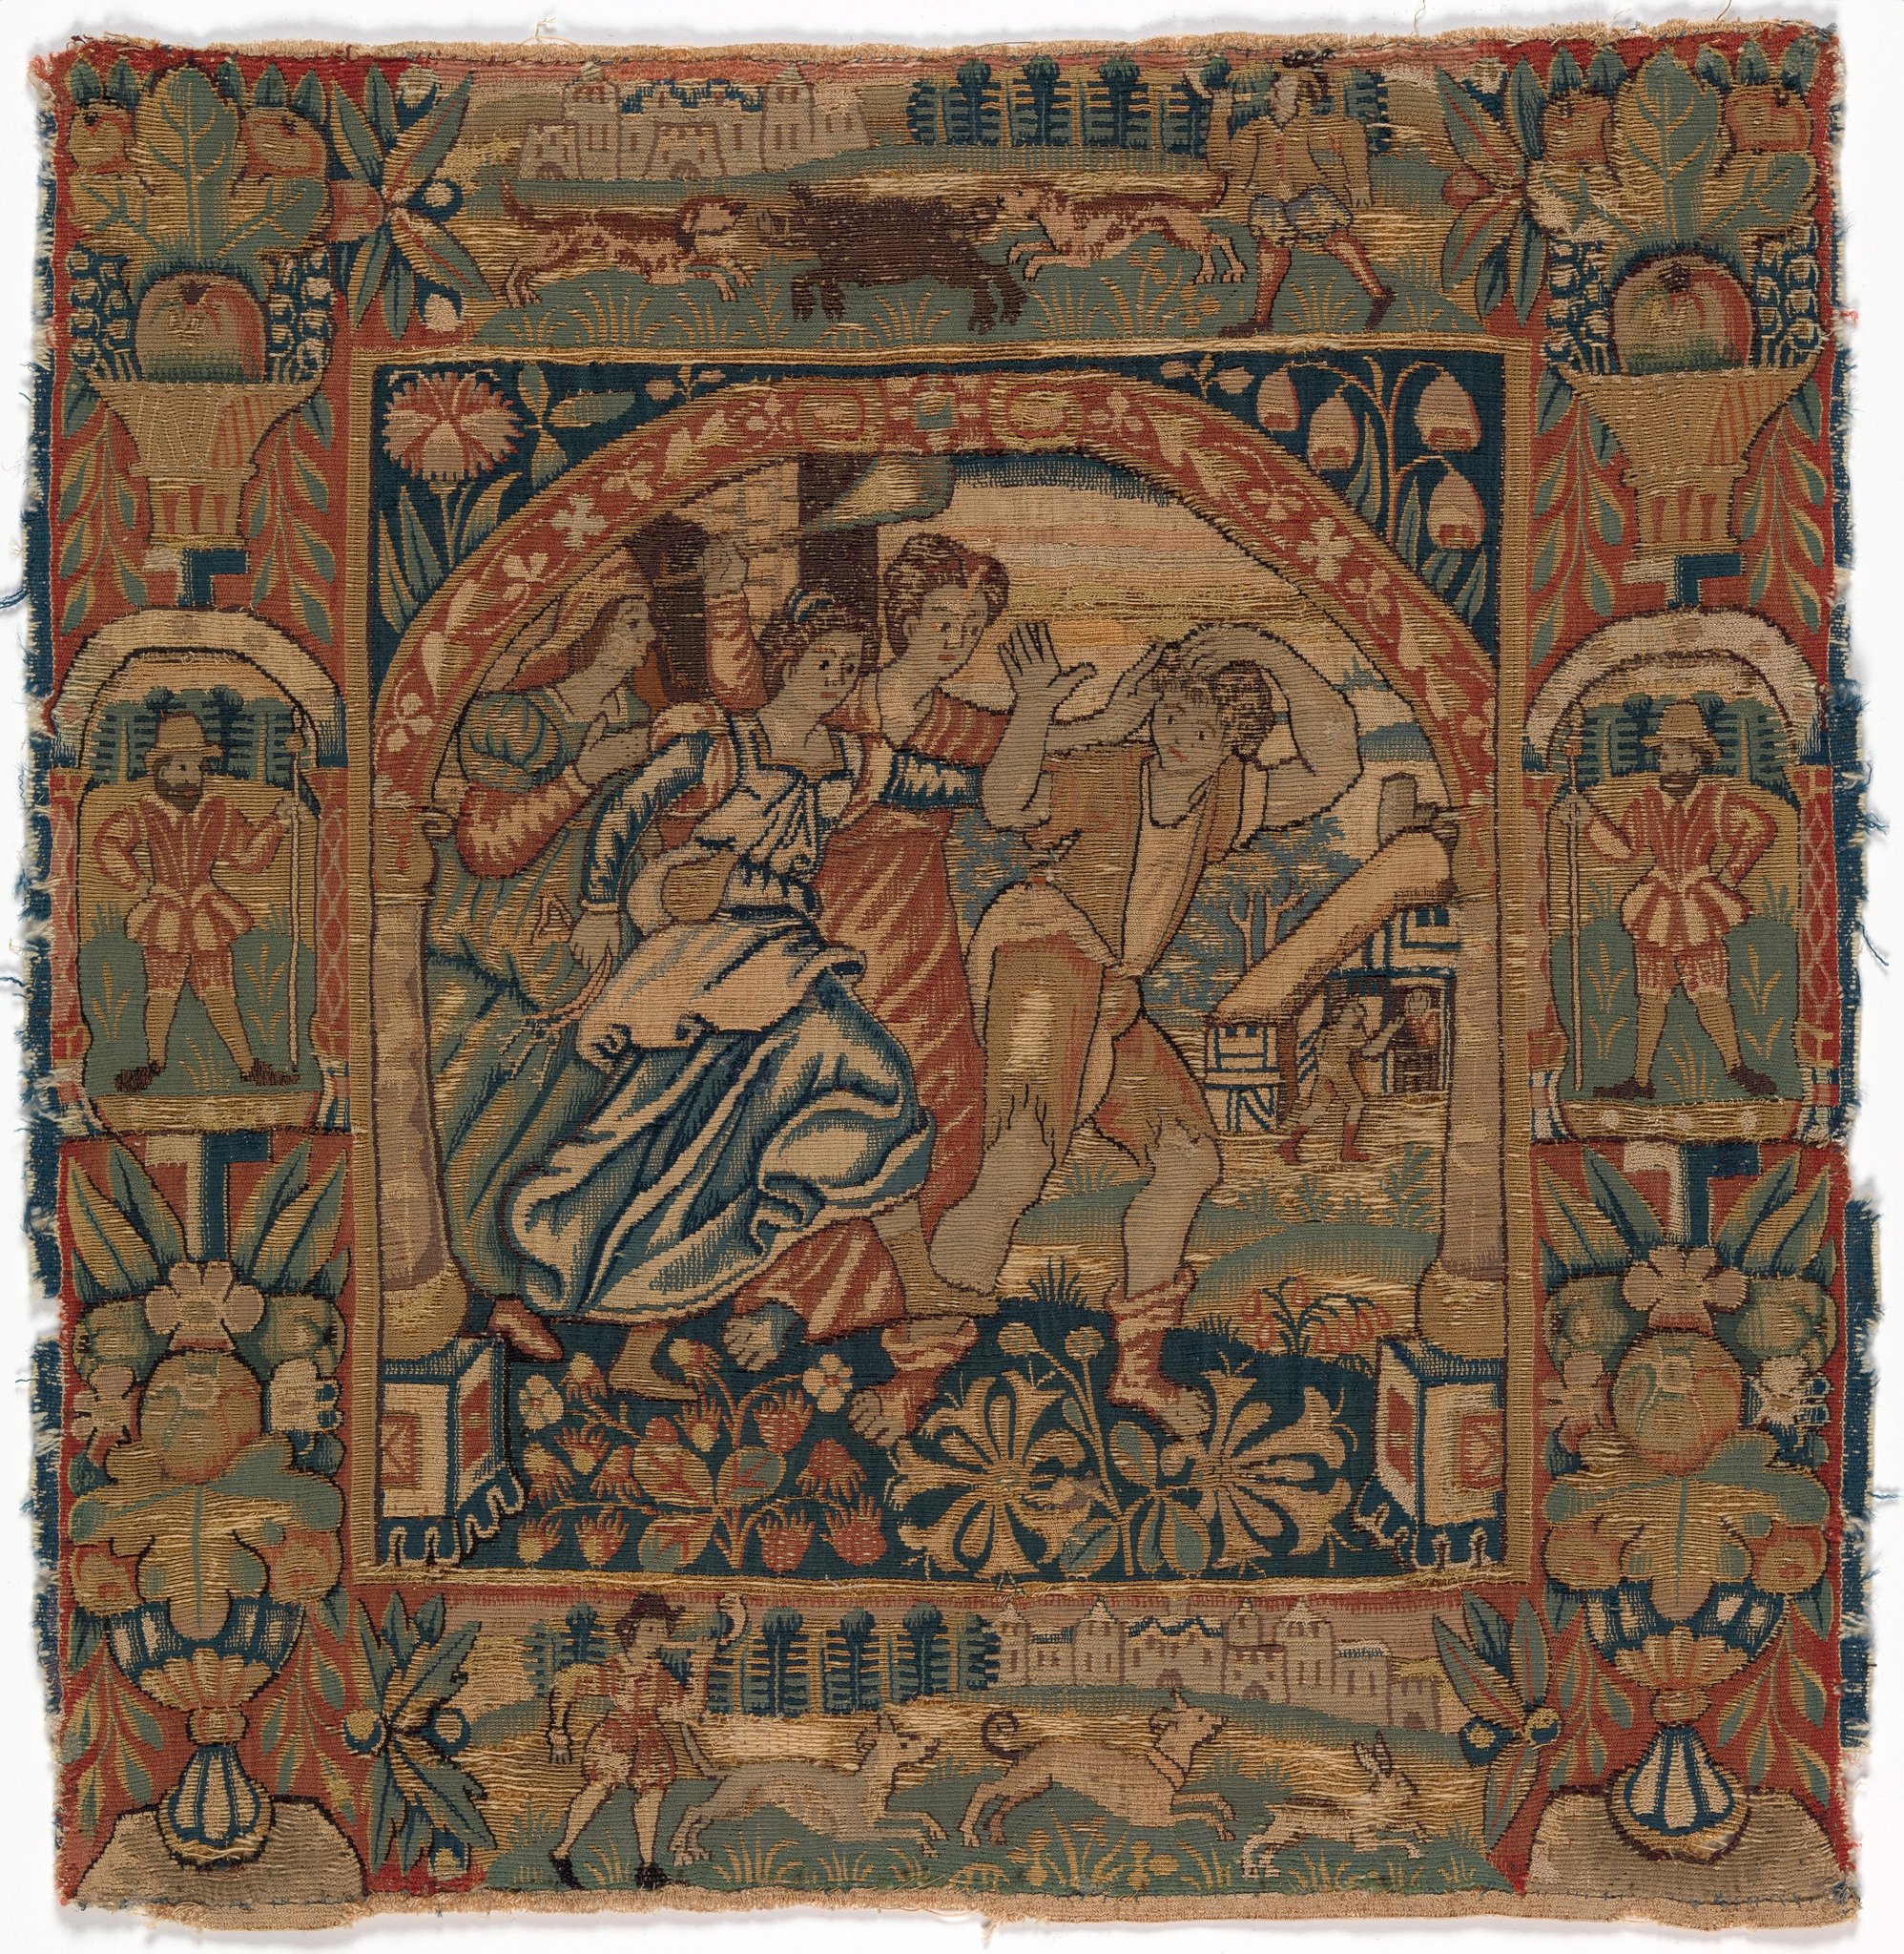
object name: cushion cover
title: "The Prodigal Son Driven Out by Harlots" from a set of six of The Parable of the Prodigal Son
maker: anonymous workshop, british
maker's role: artist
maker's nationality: british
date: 1601-1633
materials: silk, wool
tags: men,women,dogs,flowers